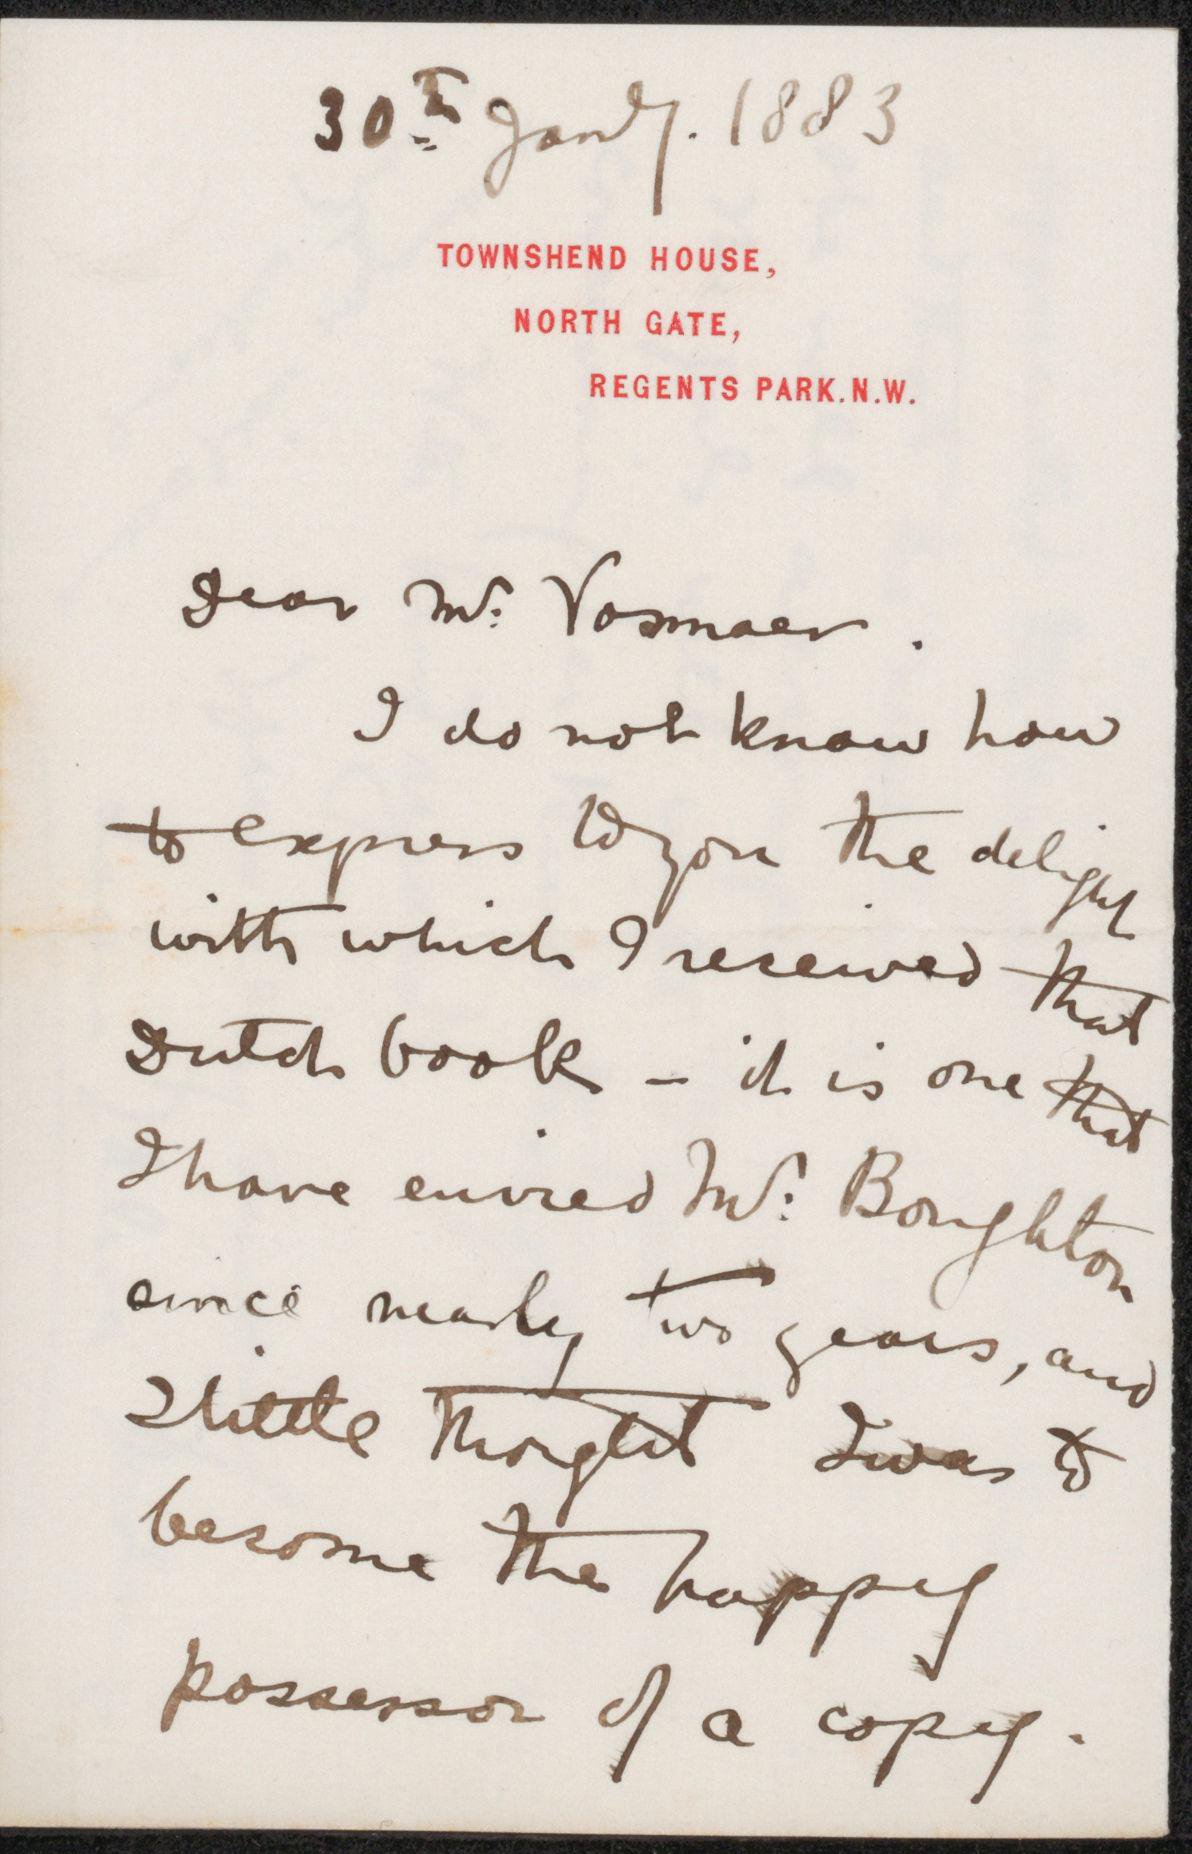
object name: letter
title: Brief aan Carel Vosmaer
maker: laura theresa alma tadema (lady)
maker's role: painter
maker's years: 1852-1909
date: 1883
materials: ink, paper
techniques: pen, printing, writing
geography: london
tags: the hague, print maker, draughtsman, carel vosmaer, london, painter, george henry boughton, literature ~ arts, printed matter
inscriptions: watermark